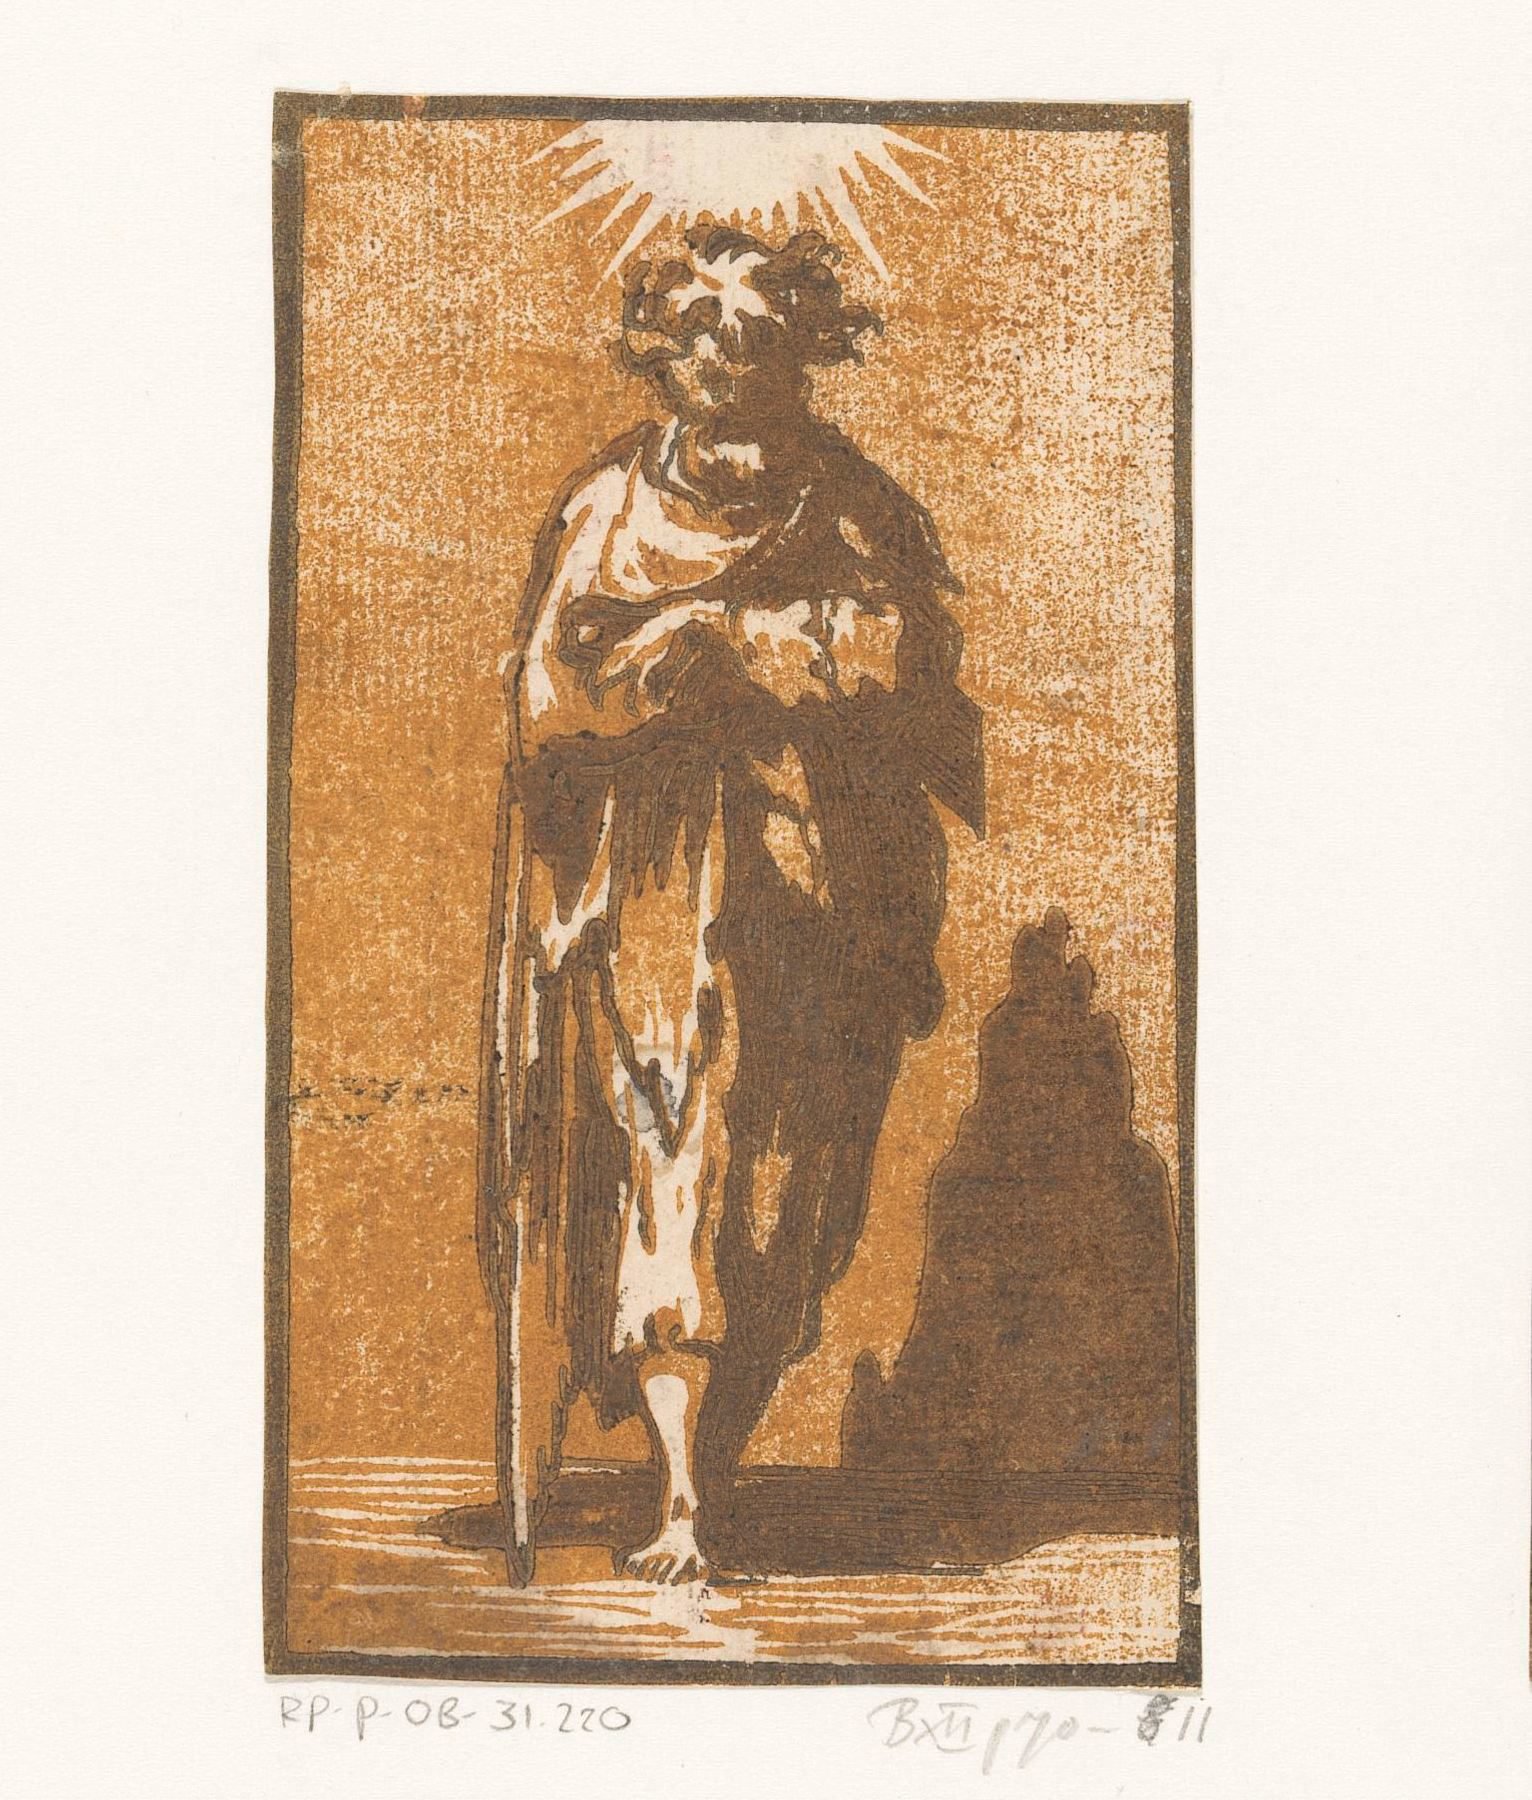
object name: print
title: Heilige Judas Taddeüs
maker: antonio da trento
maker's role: painter, print maker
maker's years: 1510-1550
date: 1520-1550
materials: paper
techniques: woodcut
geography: italy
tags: the apostle jude thaddaeus; possible attributes: book, club, halberd, scroll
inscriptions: collector's mark: Lugt 240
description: Deze prent maakt deel uit van een serie bestaande uit dertien prenten met Christus en de apostelen als staande figuren. De serie is incompleet.